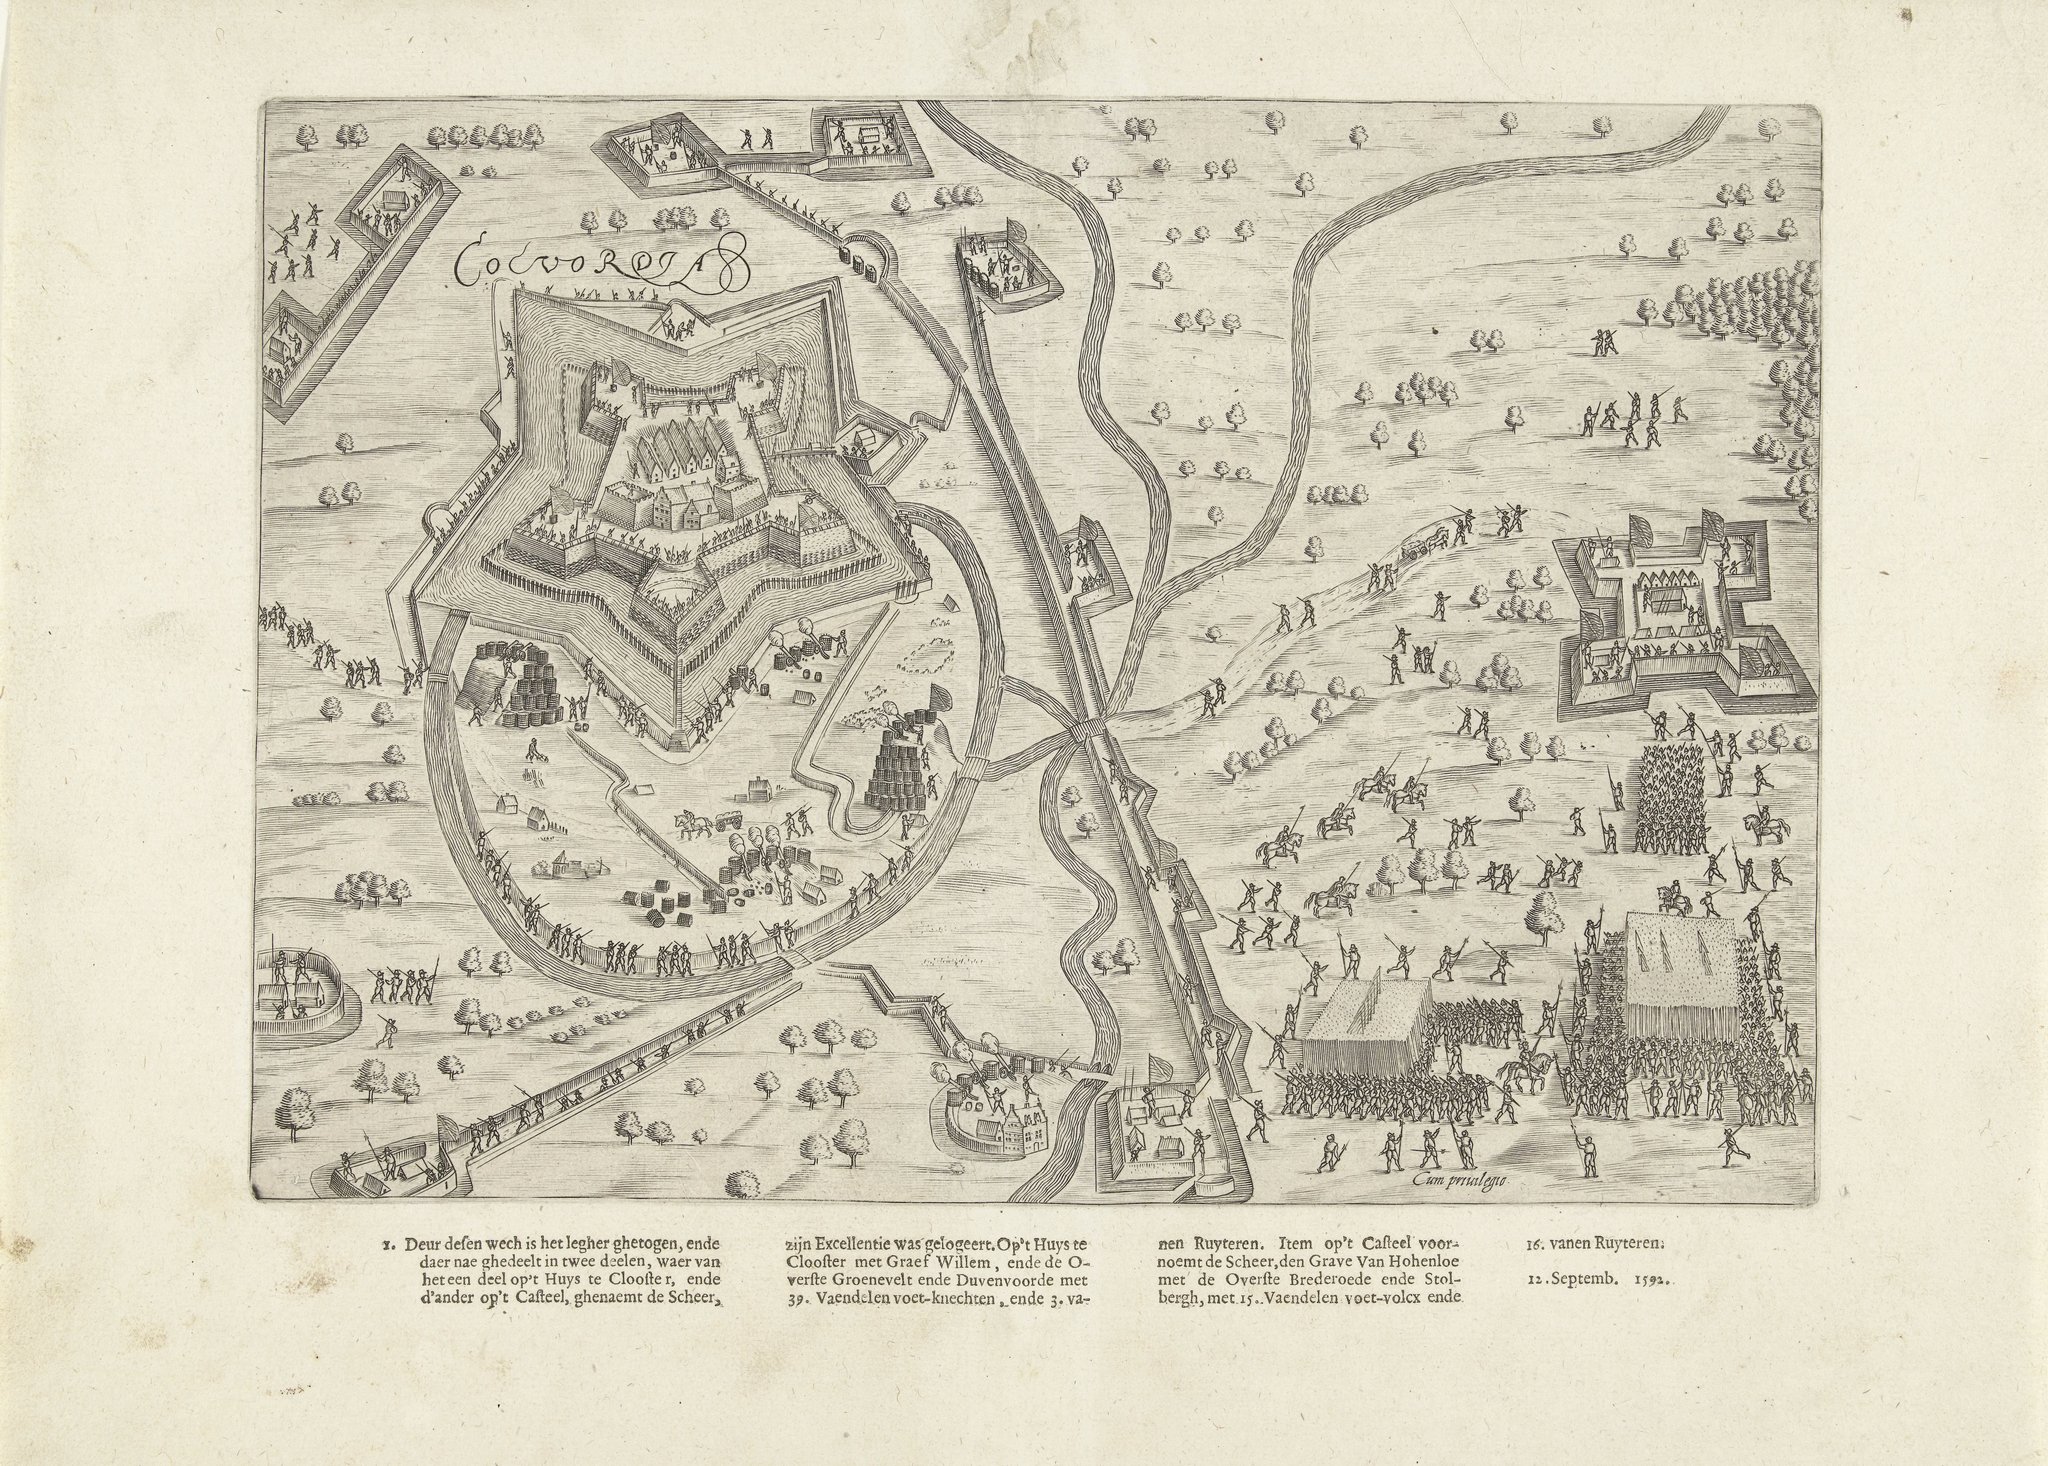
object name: print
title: Beleg van Coevorden, 1592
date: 1600-1601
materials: paper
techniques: engraving, letterpress printing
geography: northern netherlands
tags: the hague, maurice (prince of orange), siege, position war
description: Gebruikt als illustratie in: J.J. Orlers, Den Nassauschen Lauren-Crans: Beschrijvinghe ende af-beeldinge van alle de victorien ... die Godt Almachtich de ... Staten der Vereenichde Nederlanden verleent heeft, deur het wijs ende clouck beleyt des Hooch-ghebooren Fursts Maurits van Nassau, J.J. Orlers en H. van Haestens, Leiden 1610, fol. 88/89.